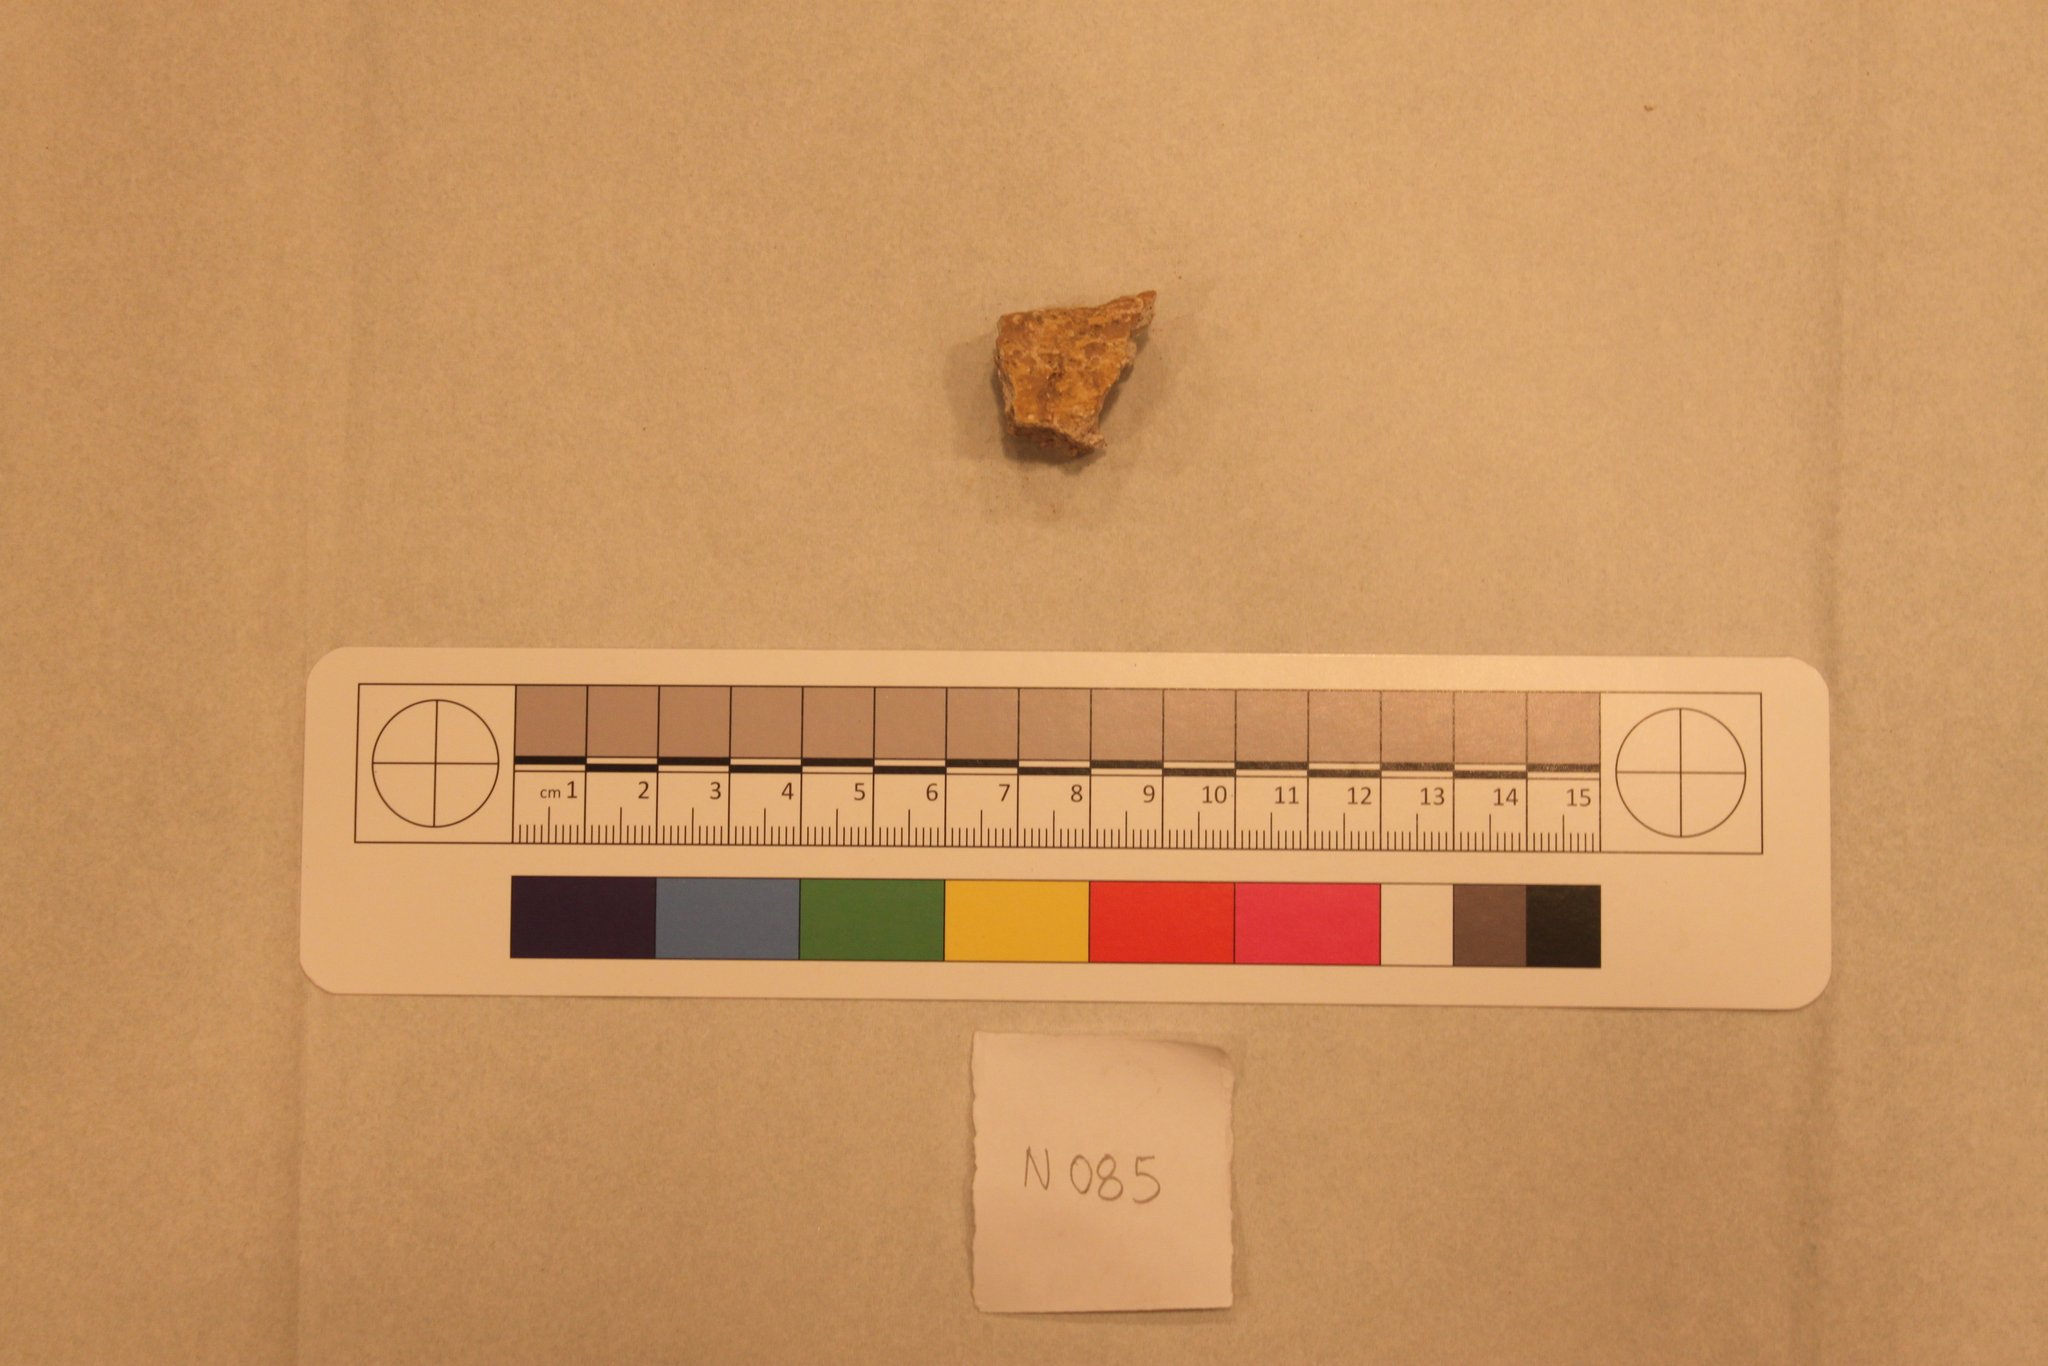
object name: fragment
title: Stucco Fragment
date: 701-1200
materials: plaster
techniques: painting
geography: iran